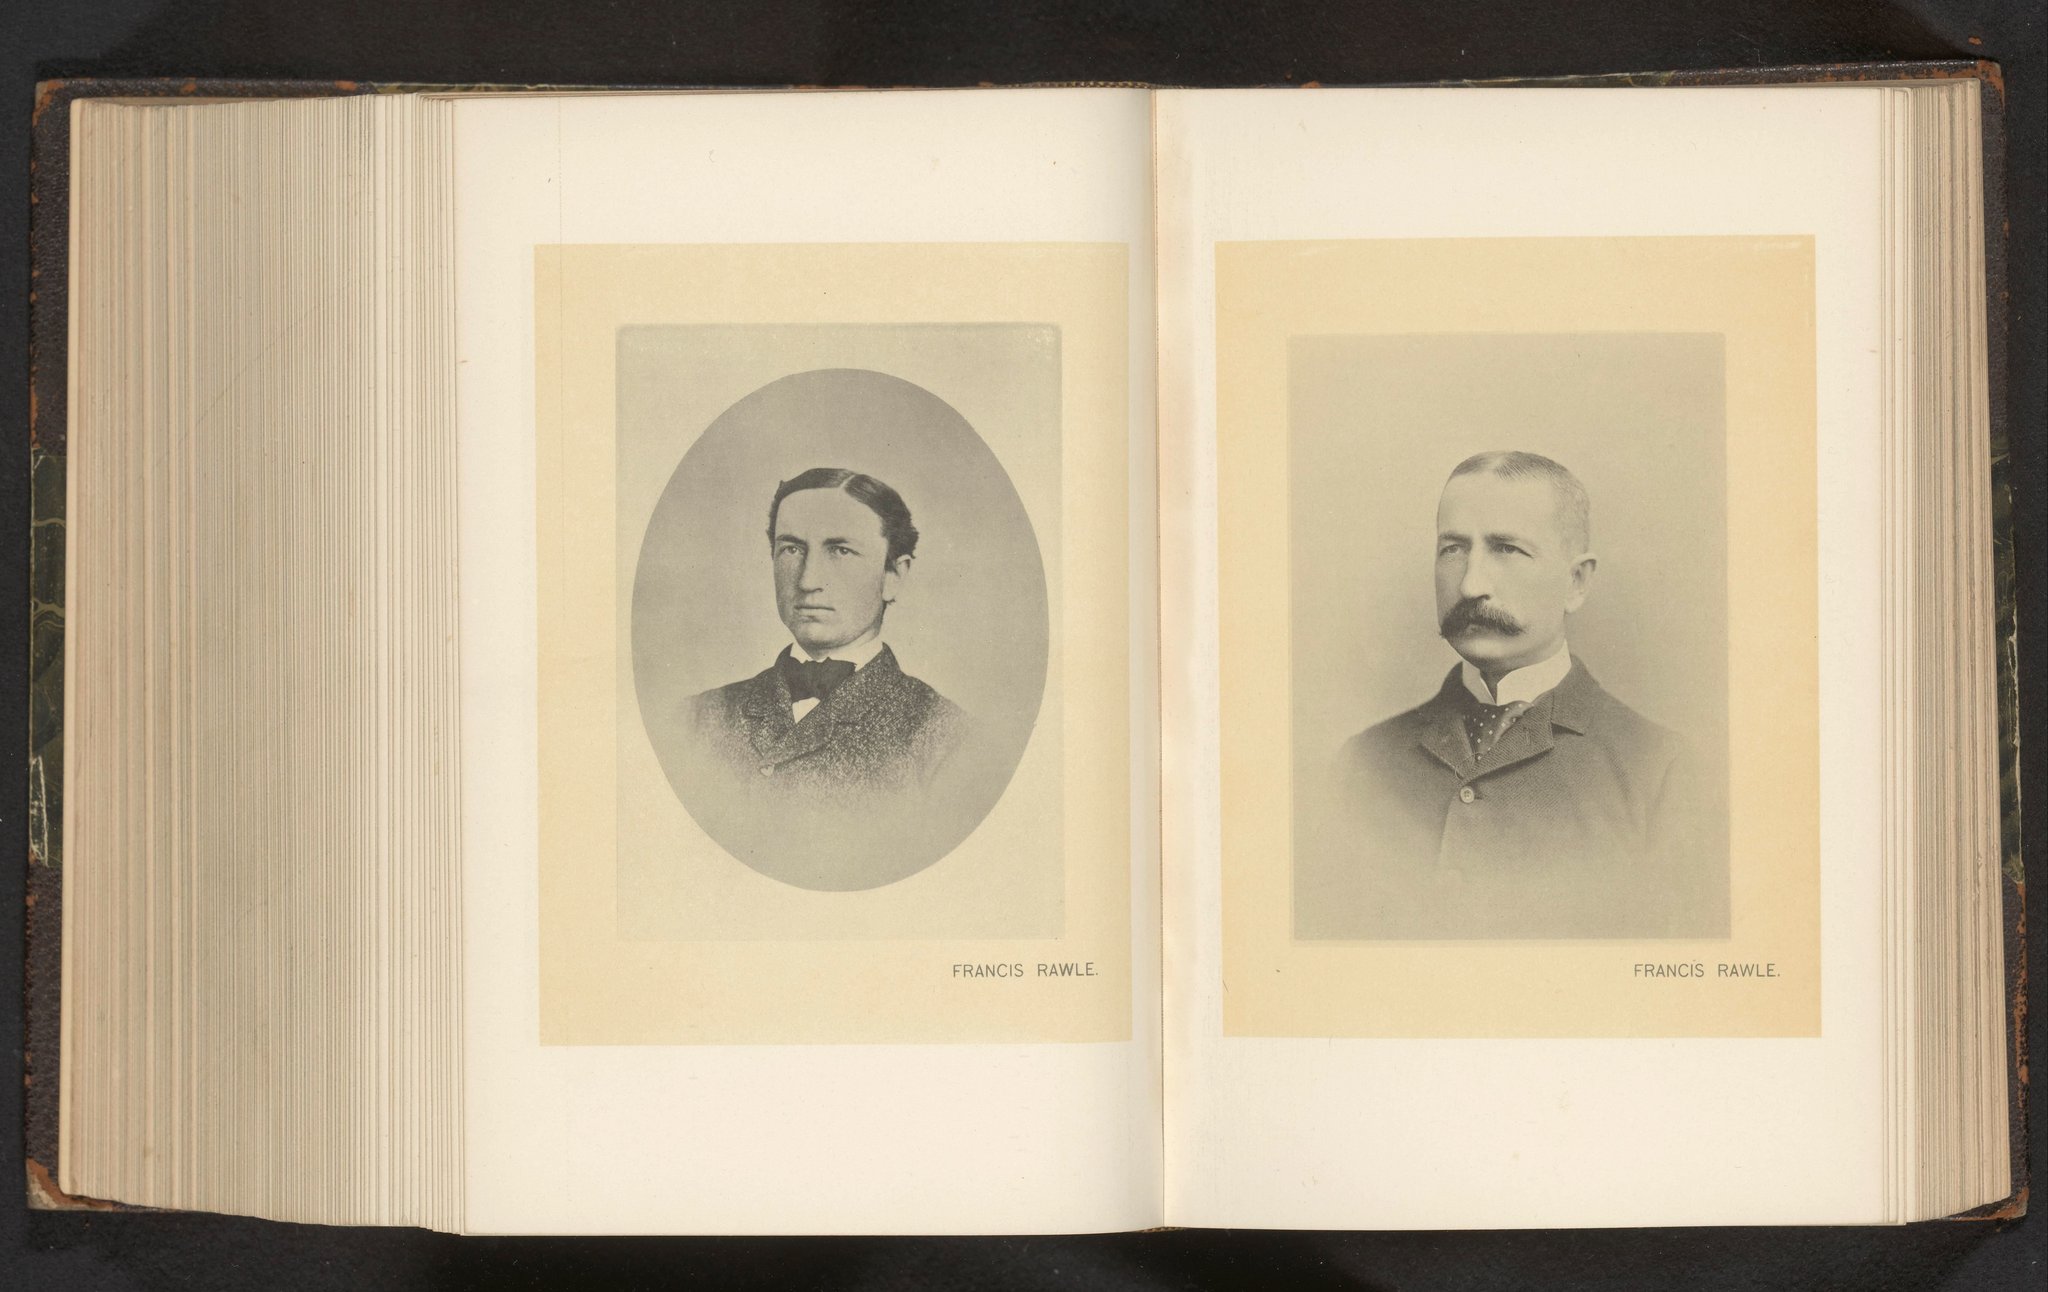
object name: photomechanical print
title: Francis Rawle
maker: Anonymous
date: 1869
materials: paper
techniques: photoaquatint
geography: boston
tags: adult man